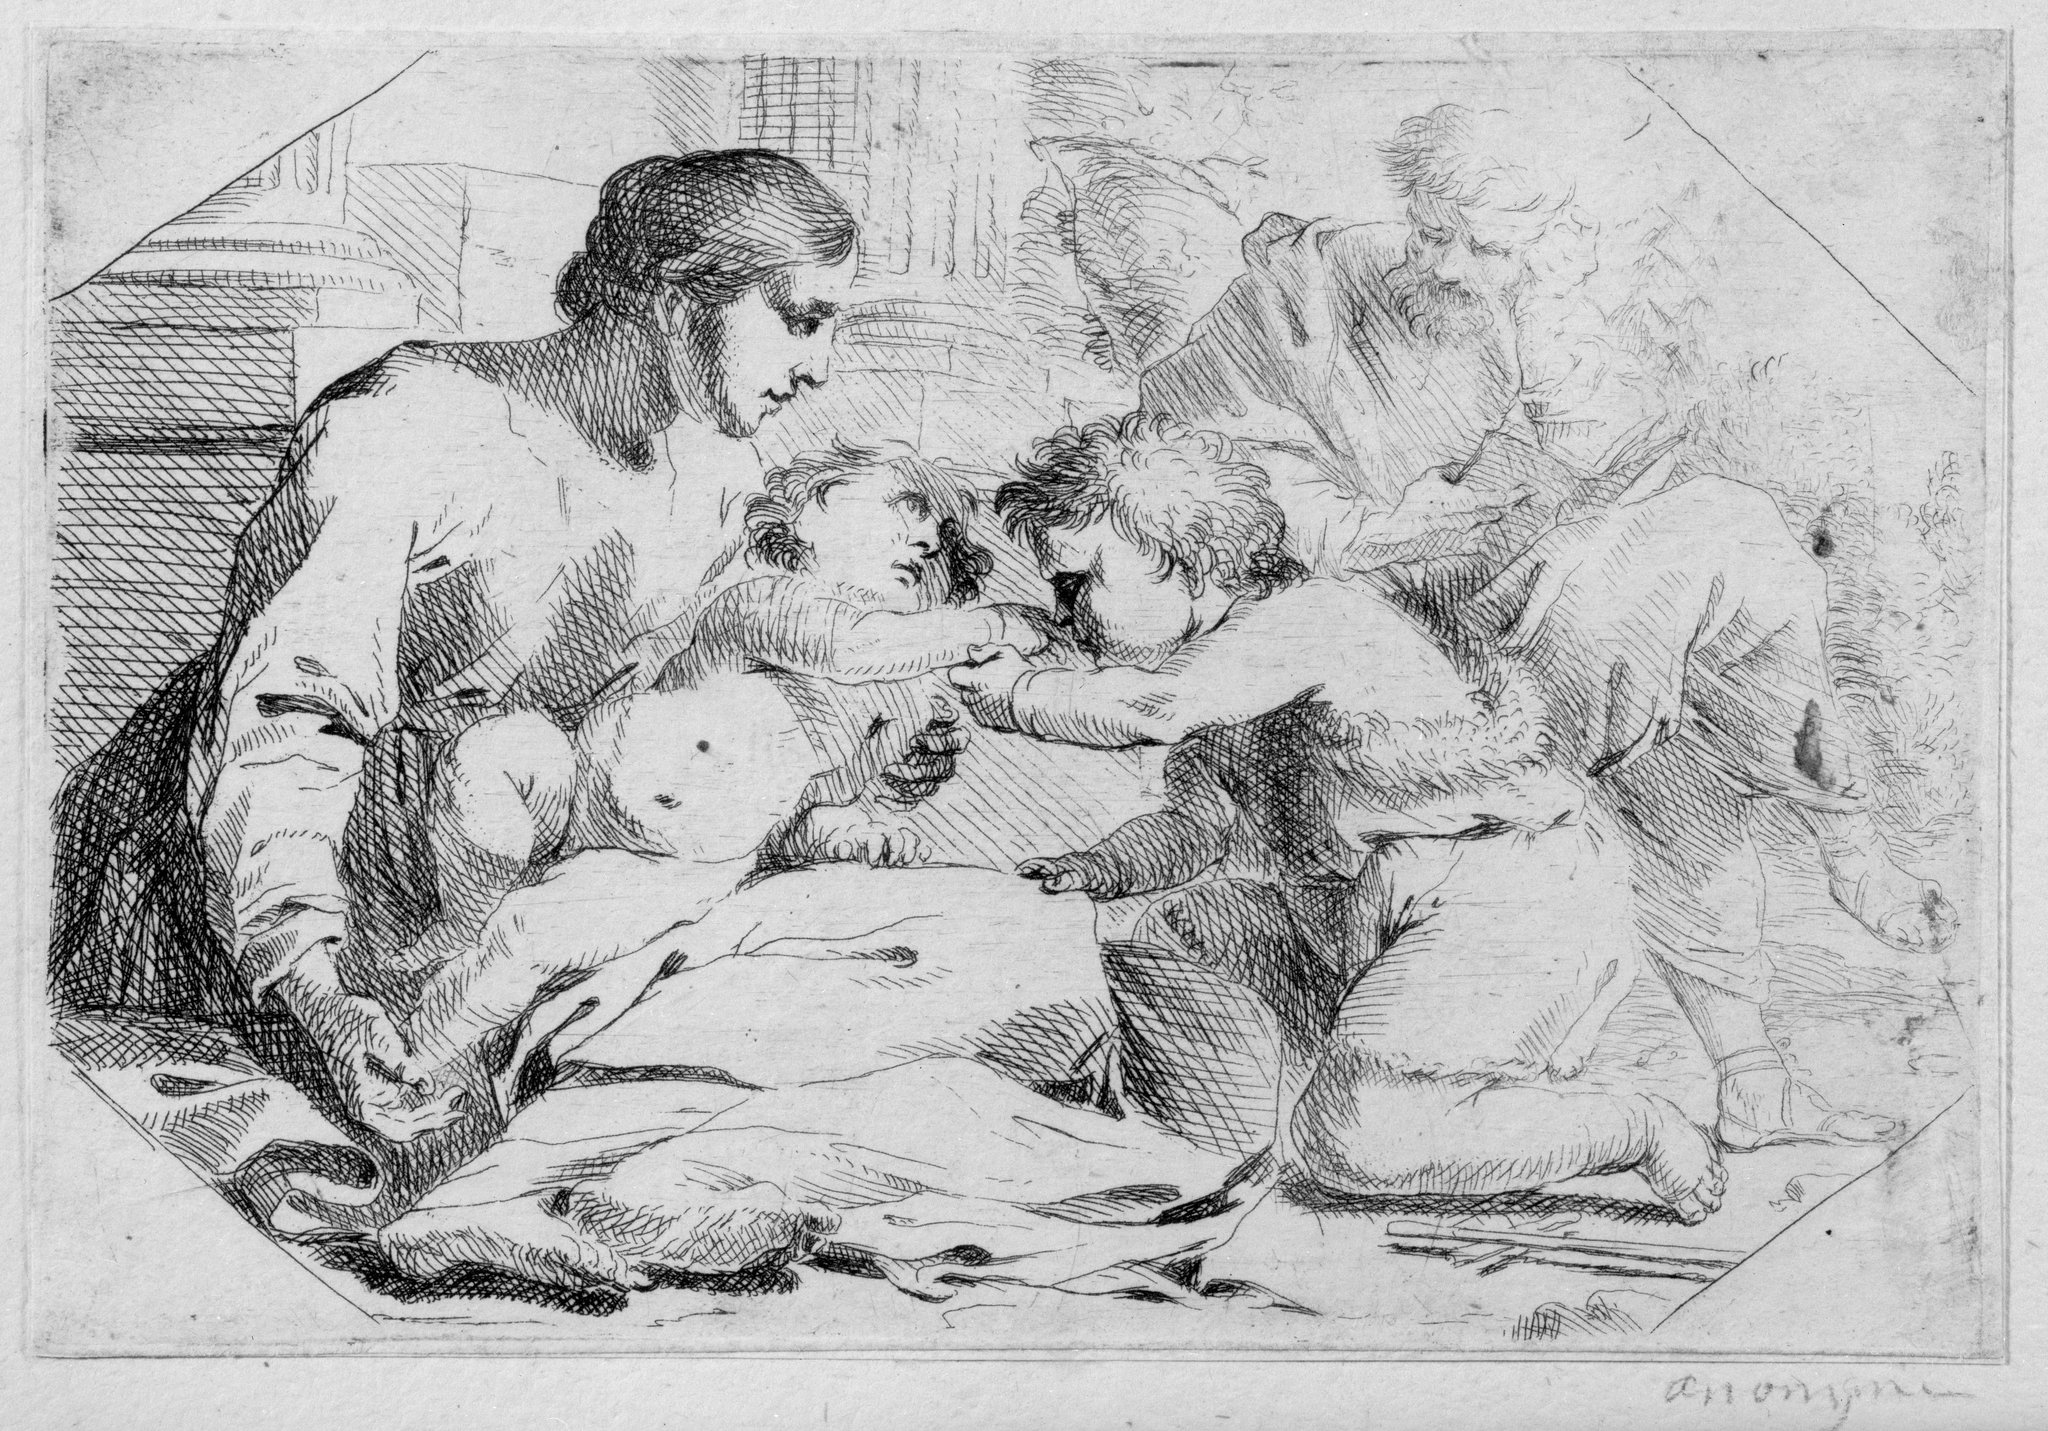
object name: print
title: The Mystic Marriage of Saint Catherine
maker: jan miele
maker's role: artist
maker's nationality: flemish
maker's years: 1599-1664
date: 1650-1657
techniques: etching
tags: men,christ,saint catherine